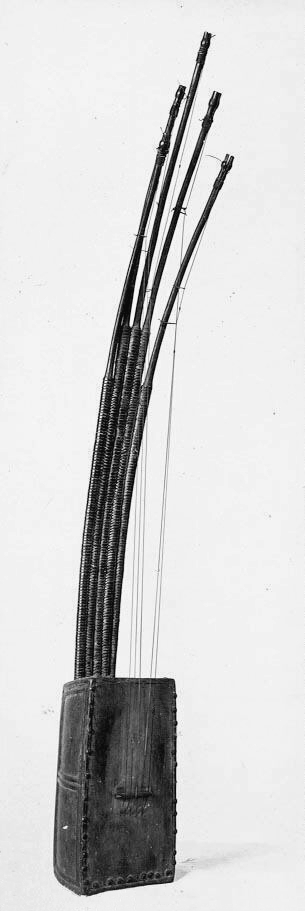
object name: wambee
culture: gabonese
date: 1867-1900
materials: wood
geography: gabon or republic of the congo